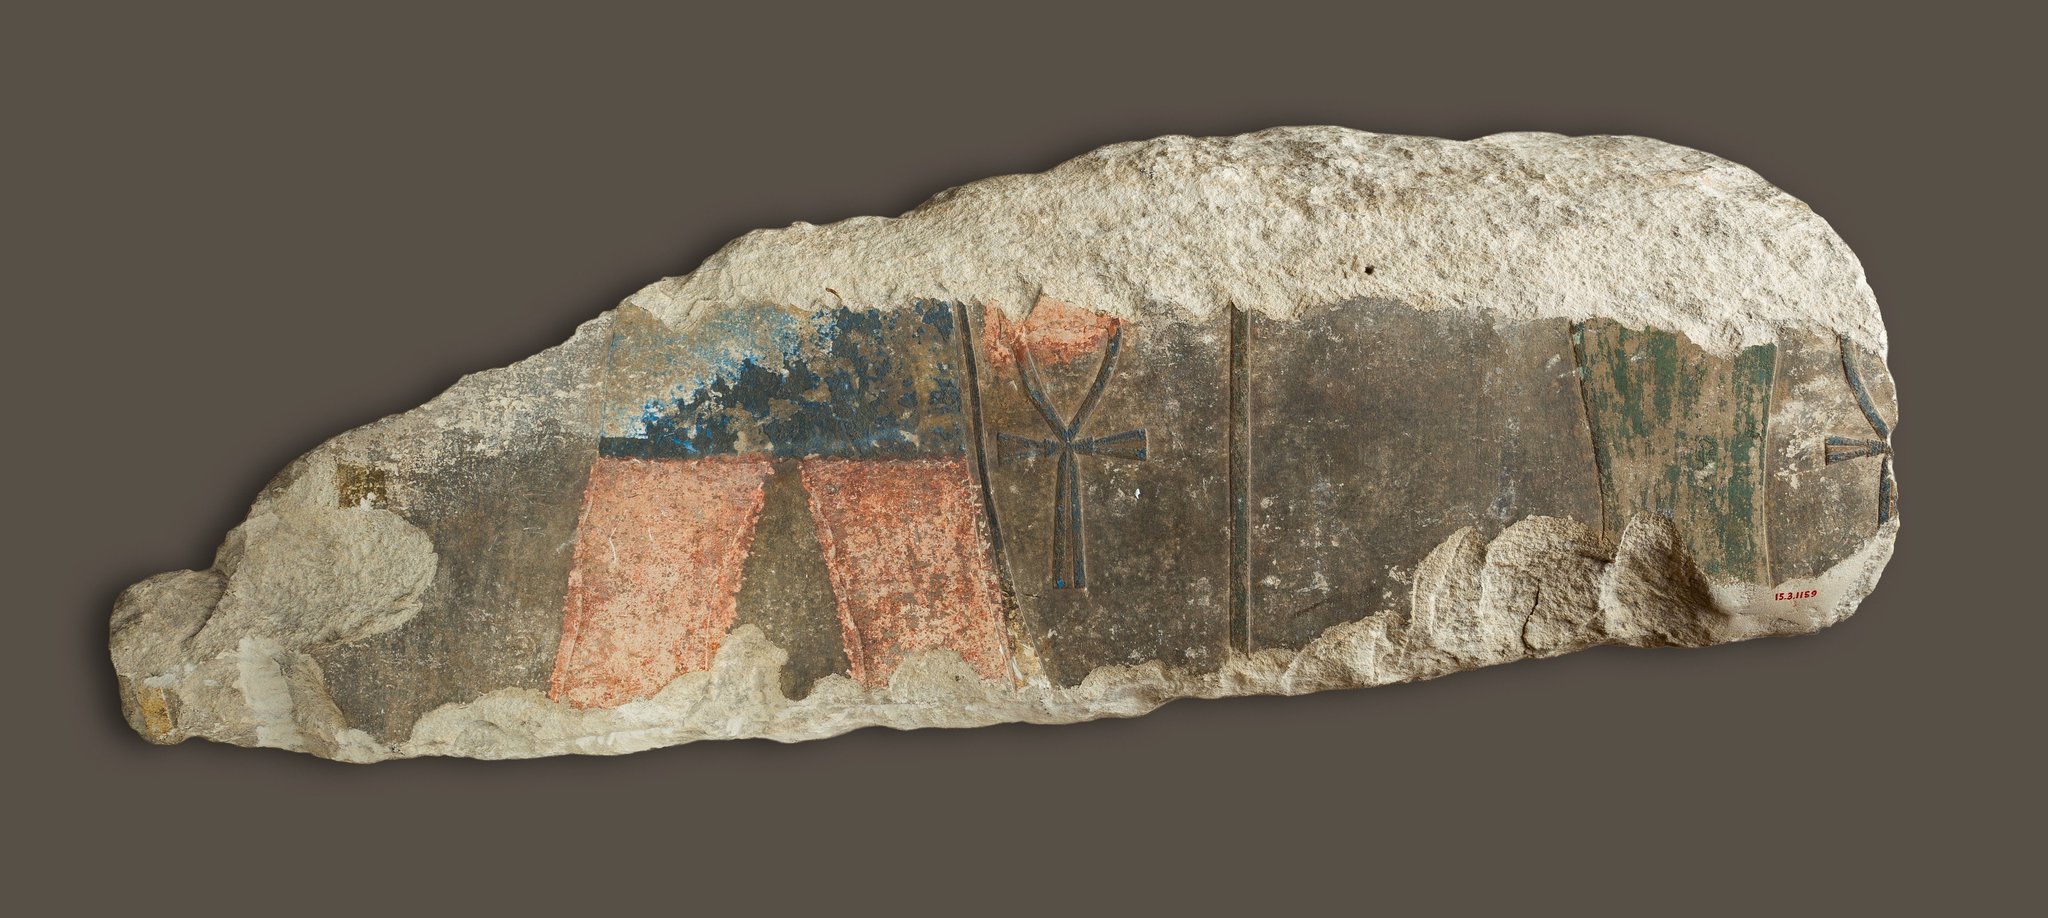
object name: relief, amenemhat i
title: Block of relief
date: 1981-1952 BCE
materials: limestone, paint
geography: egypt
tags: hieroglyphs